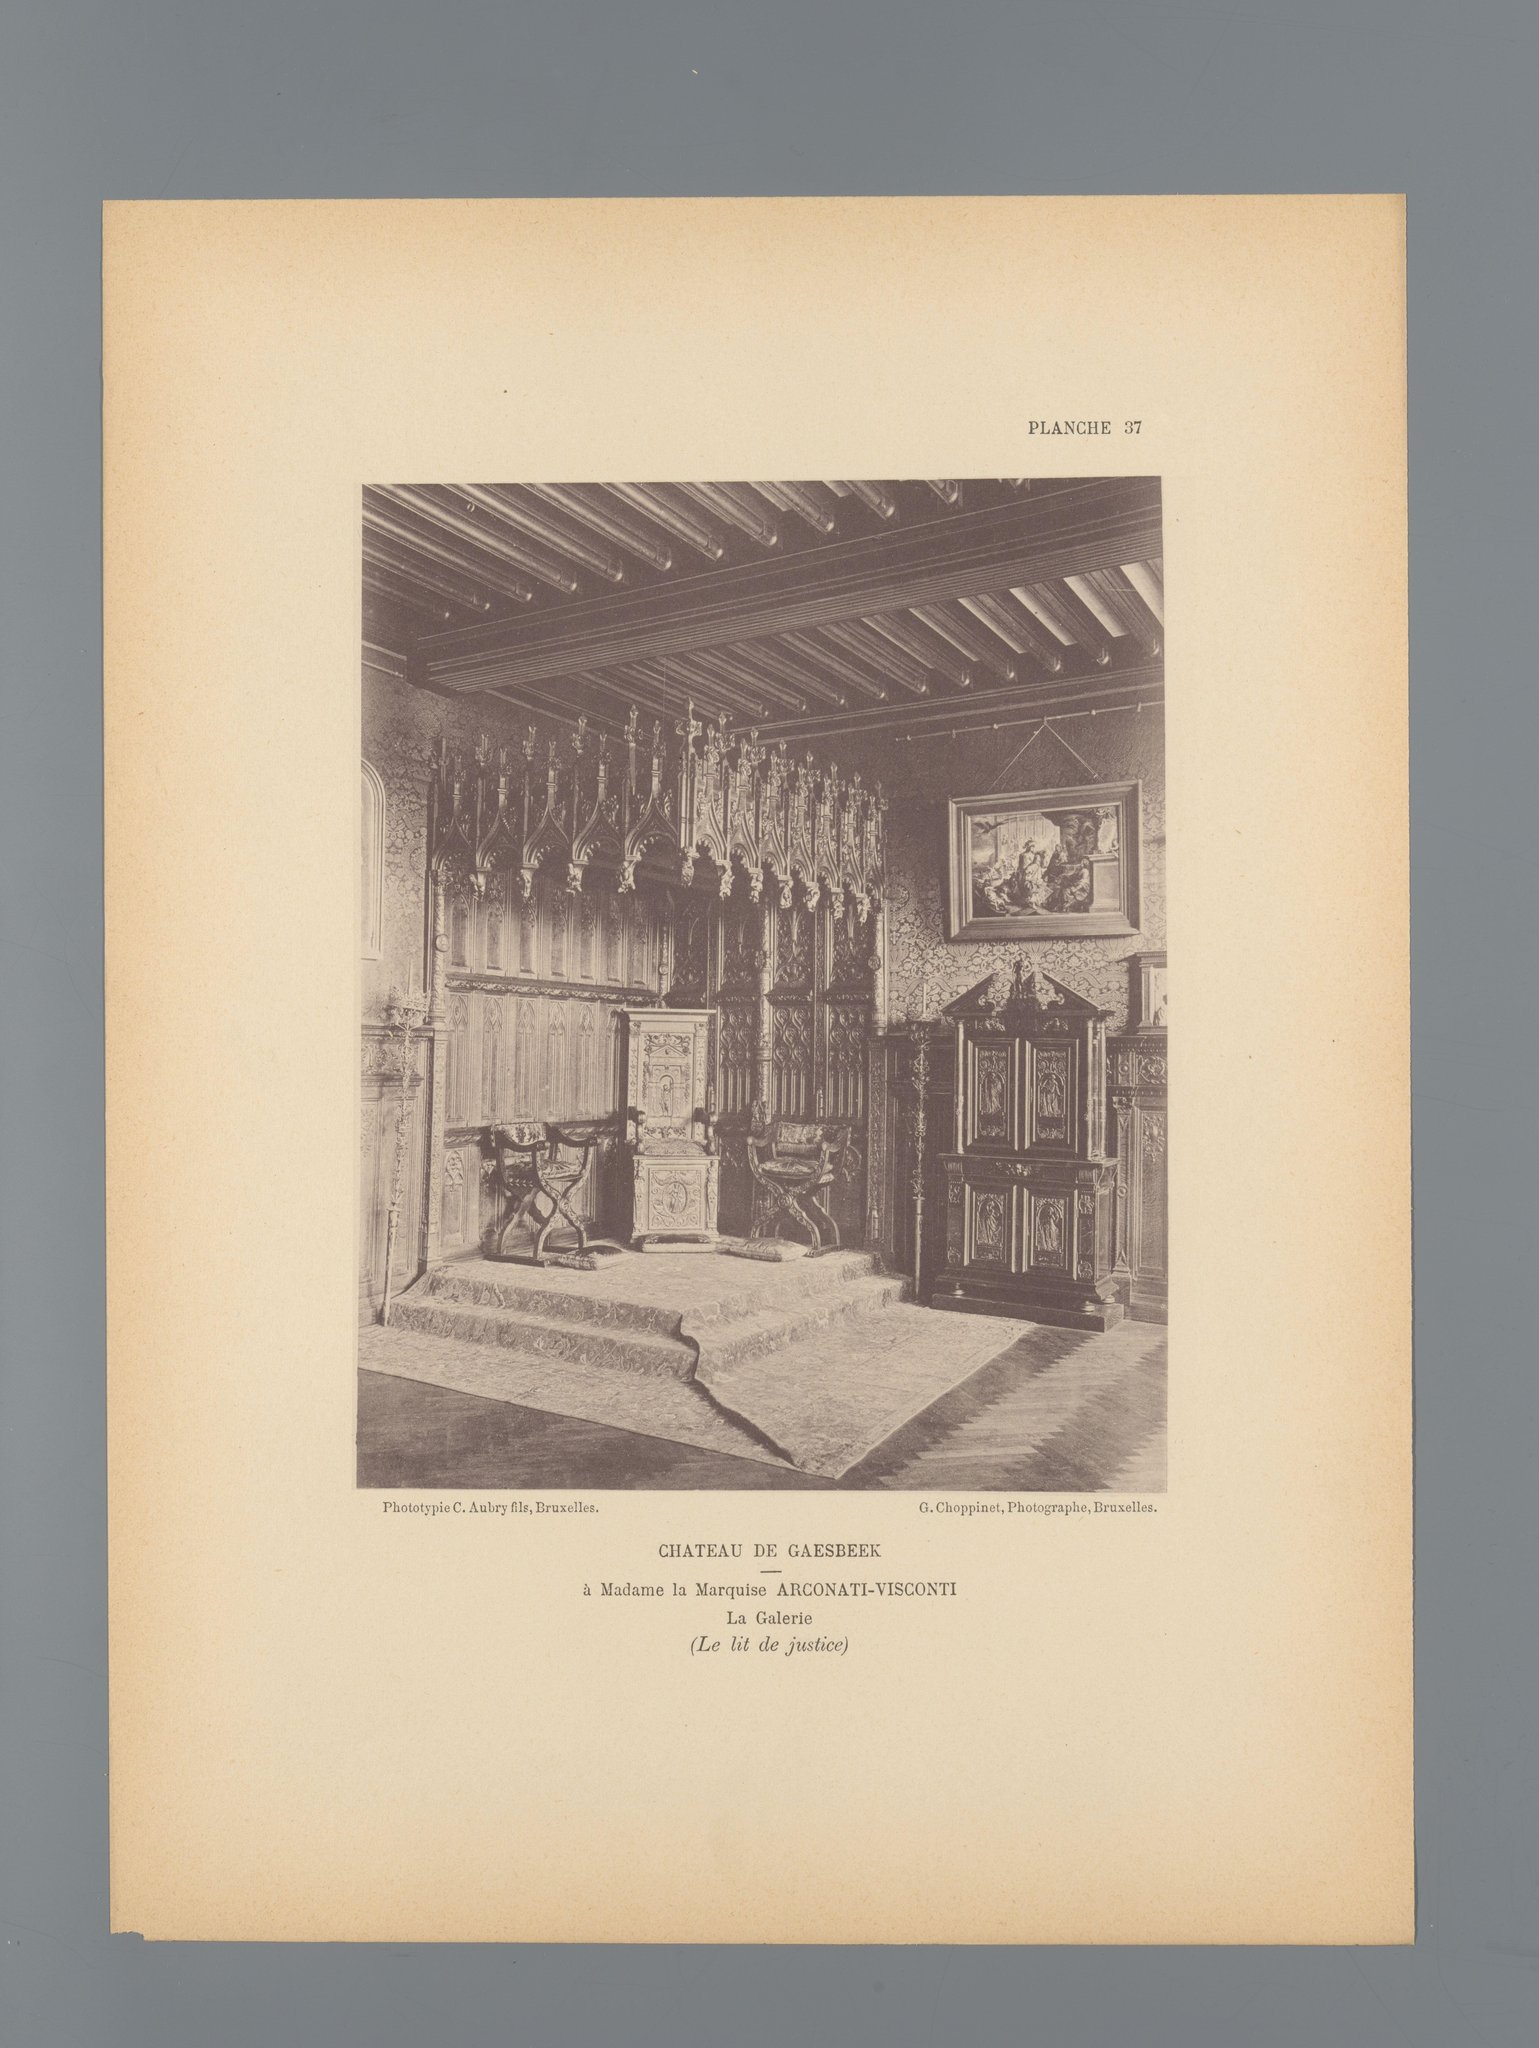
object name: photomechanical print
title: Chateau de Gaesbeek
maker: gustave choppinet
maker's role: fotograaf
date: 1893-1898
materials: paper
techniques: photograph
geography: kasteel van gaasbeek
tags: castle, symbols and allegories of jurisprudence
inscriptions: number: ‘PLANCHE 37’, inscription: ‘à Madame la Marquise ARCONATI-VISCONTI/ La Galerie/ (Le lit de justice)’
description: Deze prent maakt deel uit van een omslag met 89 prenten en 5 tekstbladen.